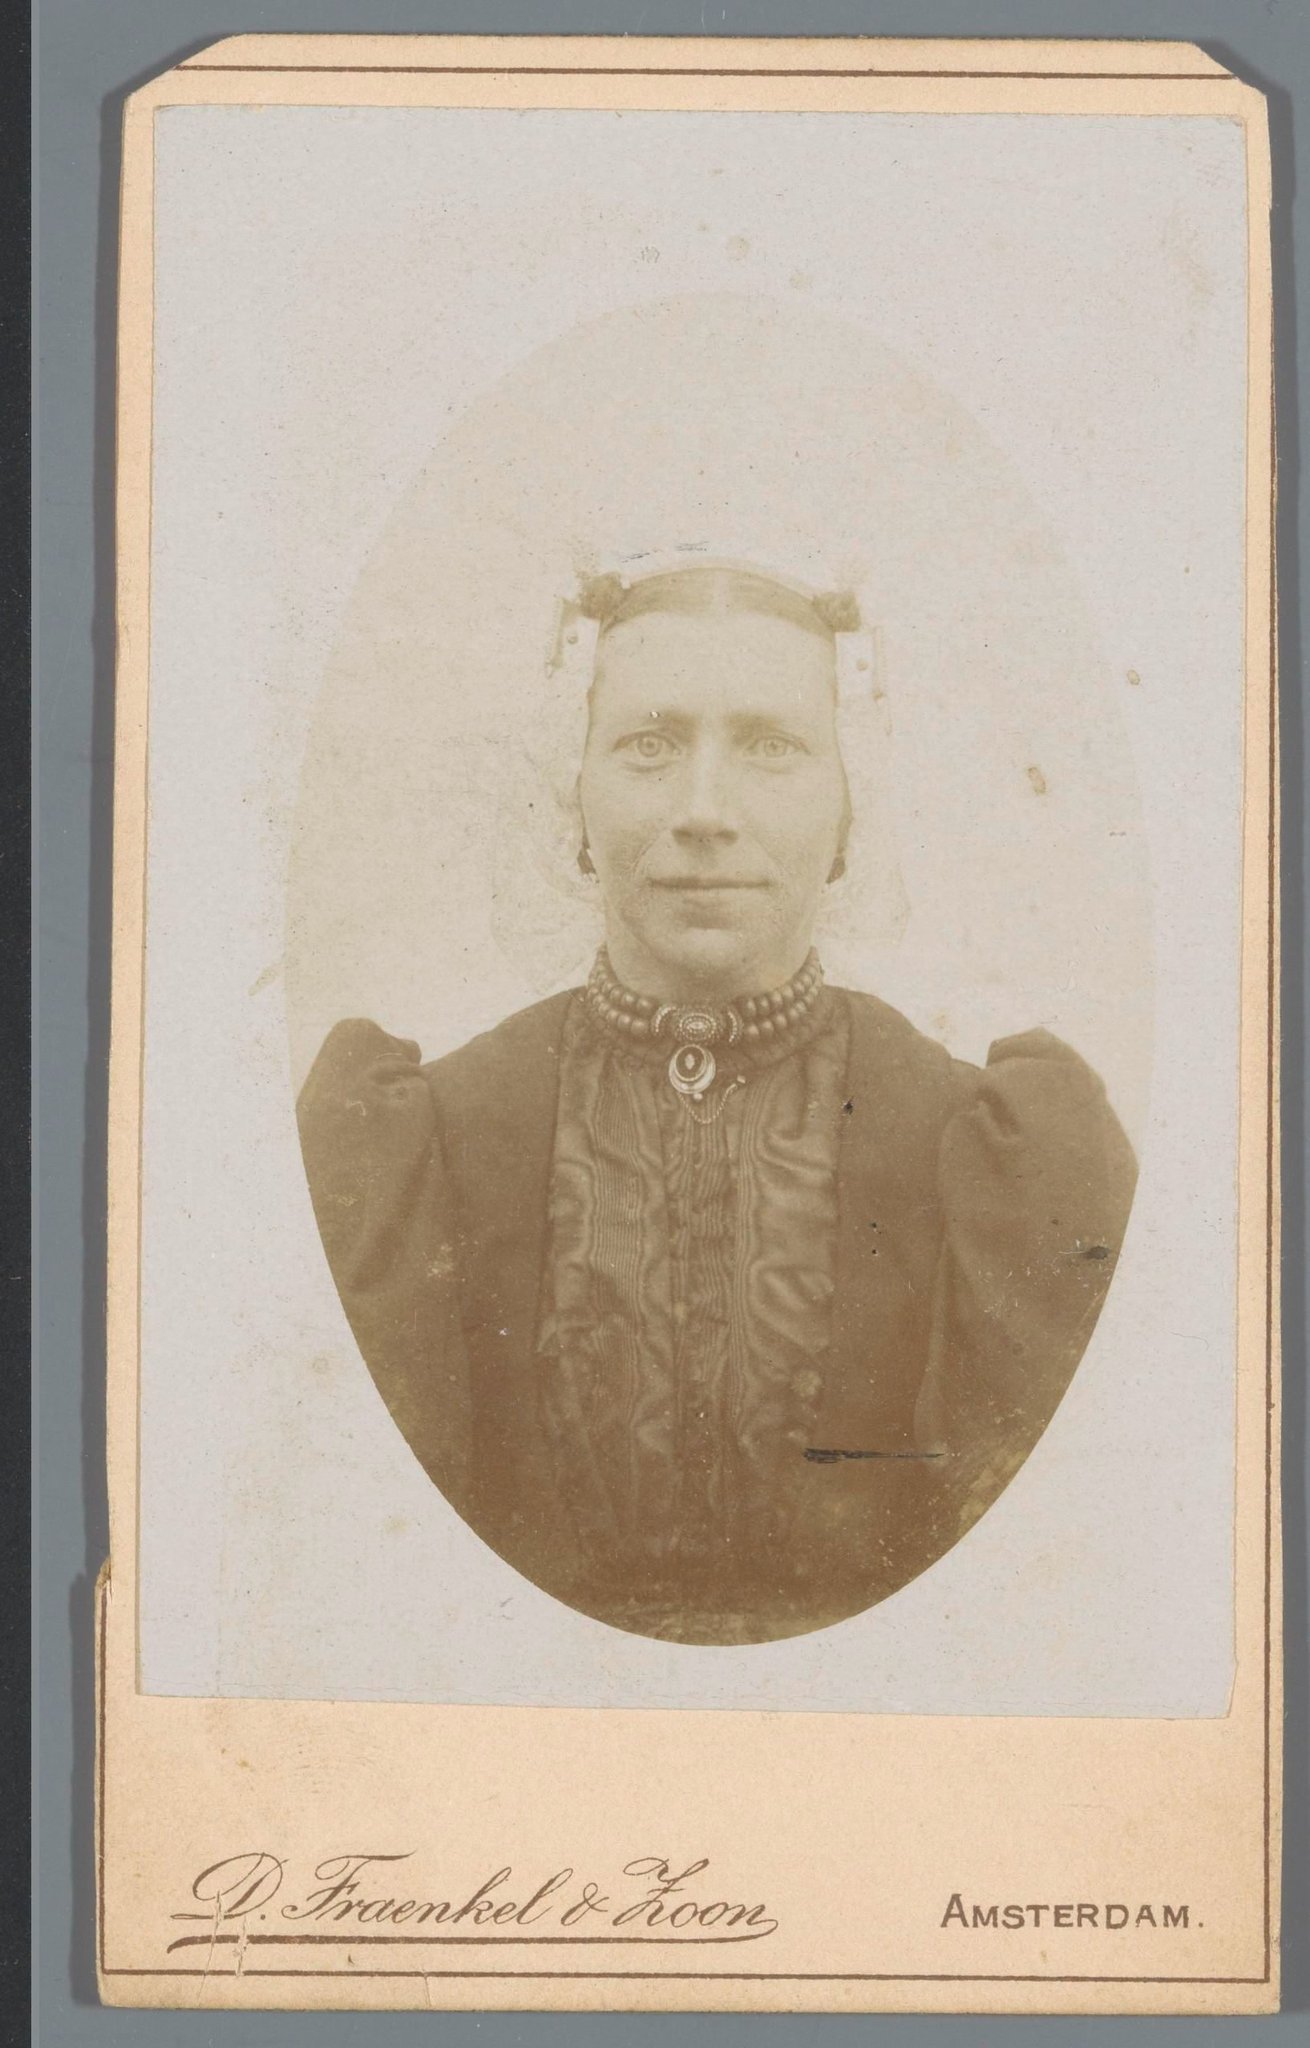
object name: carte de visite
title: Portret van Pietertje Kramer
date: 1890-1910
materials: paper, cardboard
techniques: collodion silver print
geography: amsterdam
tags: adult woman, historical persons, amsterdam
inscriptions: inscription: ‘Specialiteit in vergrootingen van deze Portretten/ kunnen steeds nabesteld worden./ ALEX:LINDNER, BERLIN.’, address: ‘Amsterdam 43. Commelinstraat 43.’, inscription: ‘Pietertje Kramer 6/ x 12 Feb. 1880/ Andries Visser’